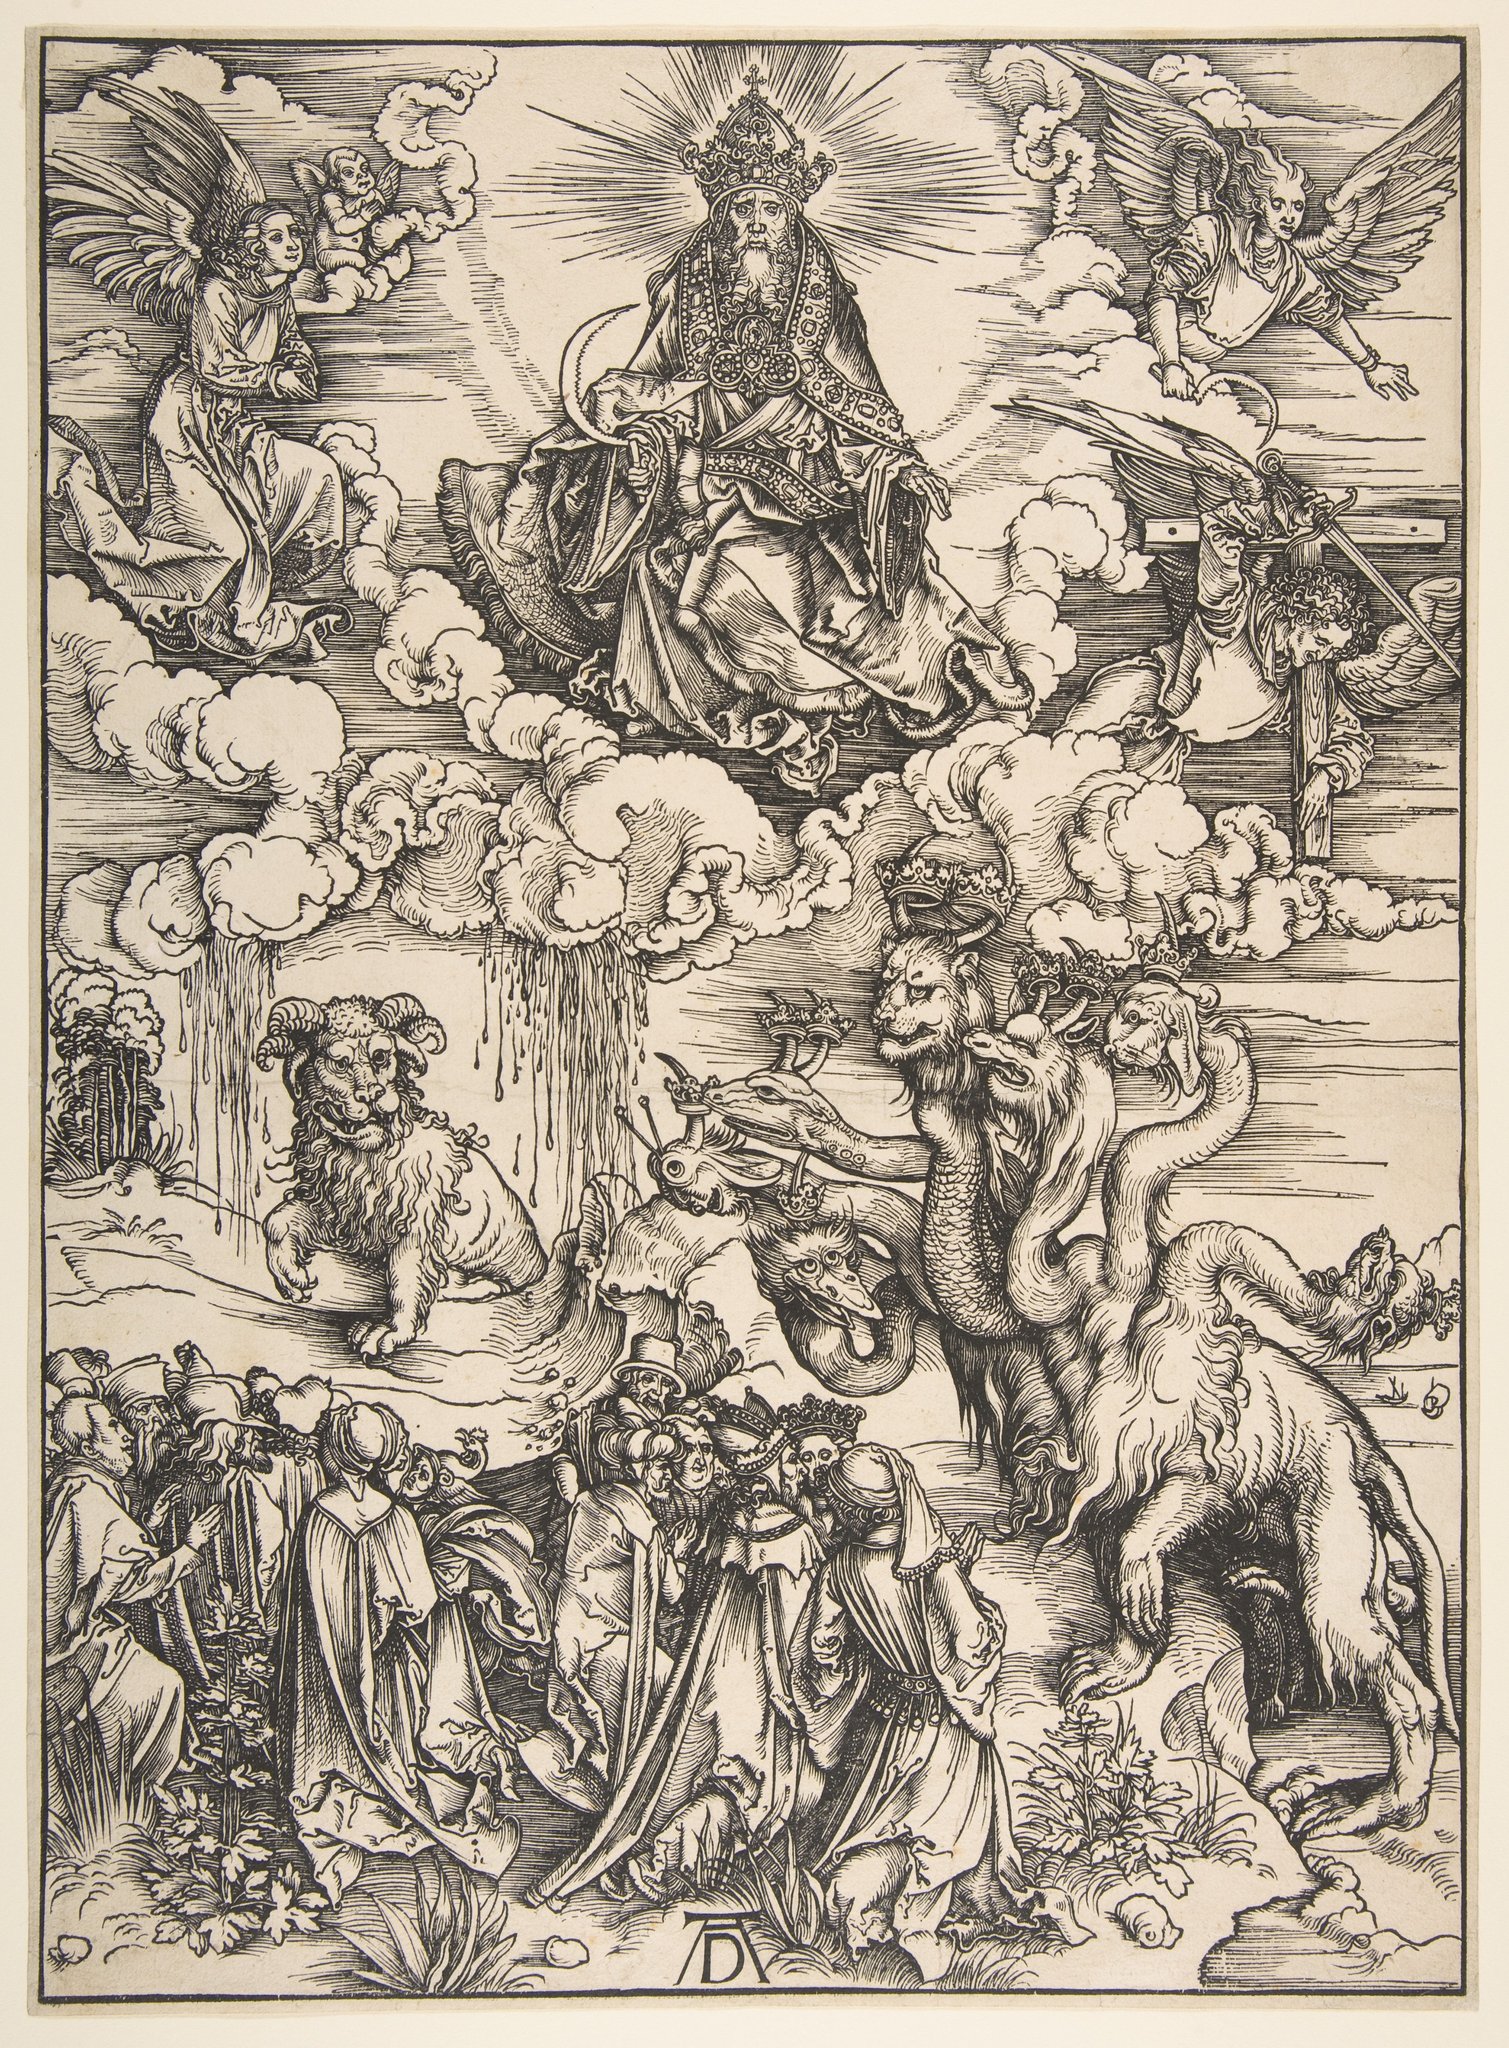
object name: print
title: The Beast with the Seven Heads and the Beast with Lamb's Horns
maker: albrecht dürer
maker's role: artist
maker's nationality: german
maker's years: 1471-1528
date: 1511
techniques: woodcut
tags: men,mythical creatures,angels